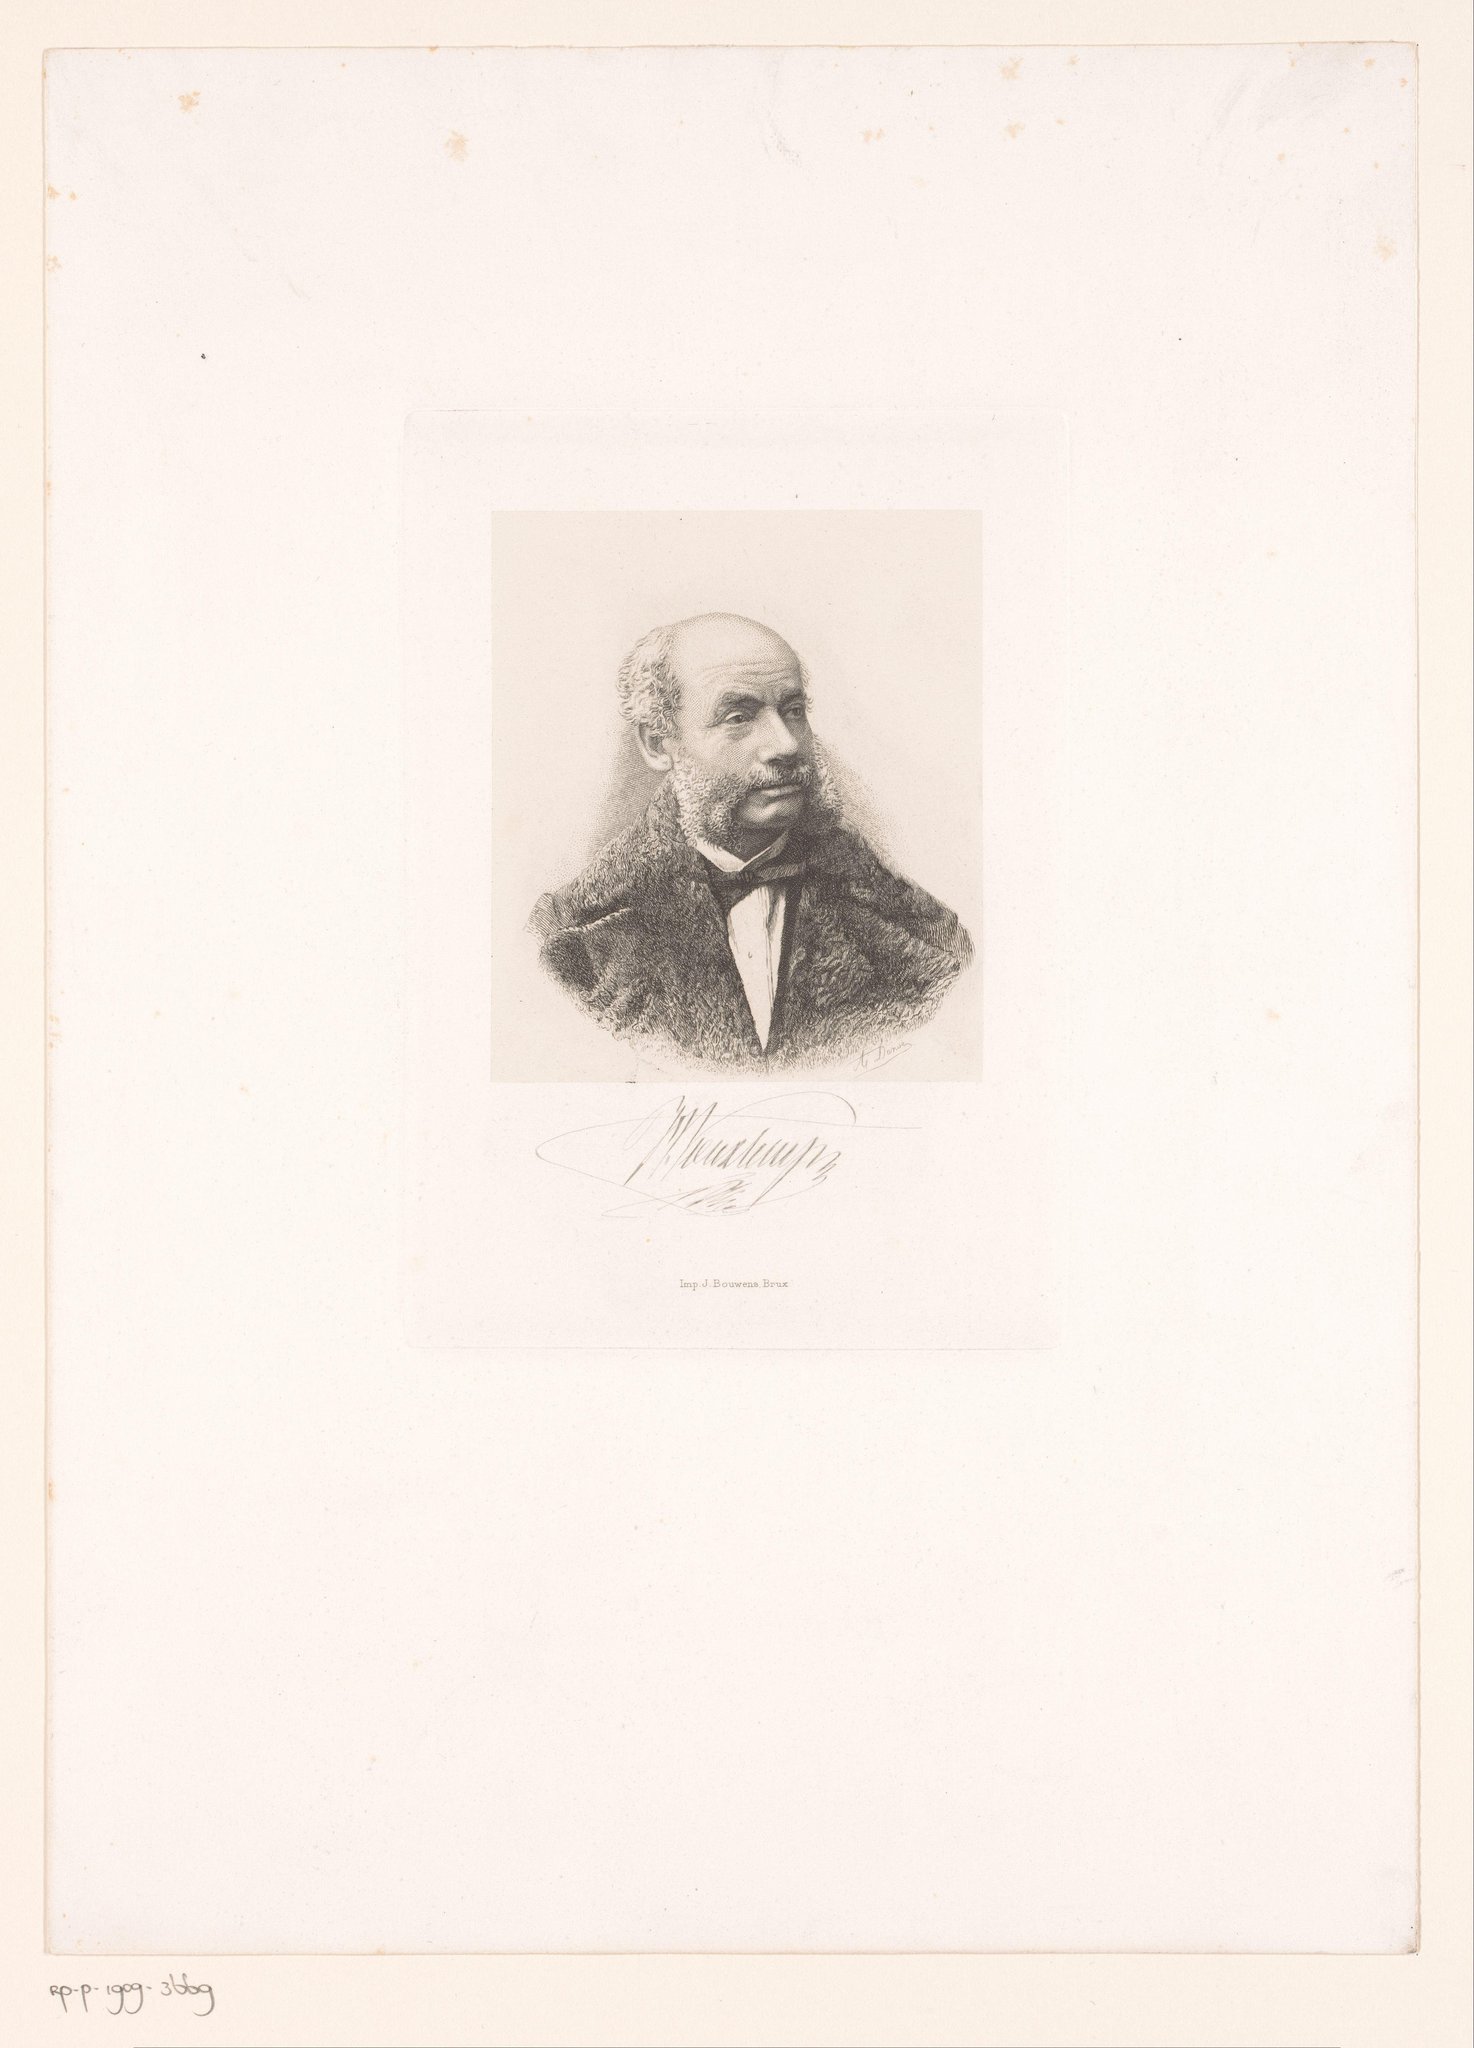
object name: print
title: Portret van Henri Vieuxtemps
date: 1881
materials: paper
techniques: etching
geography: brussels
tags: historical person (...) - historical person (...) portrayed alone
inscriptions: collector's mark: Lugt 2228